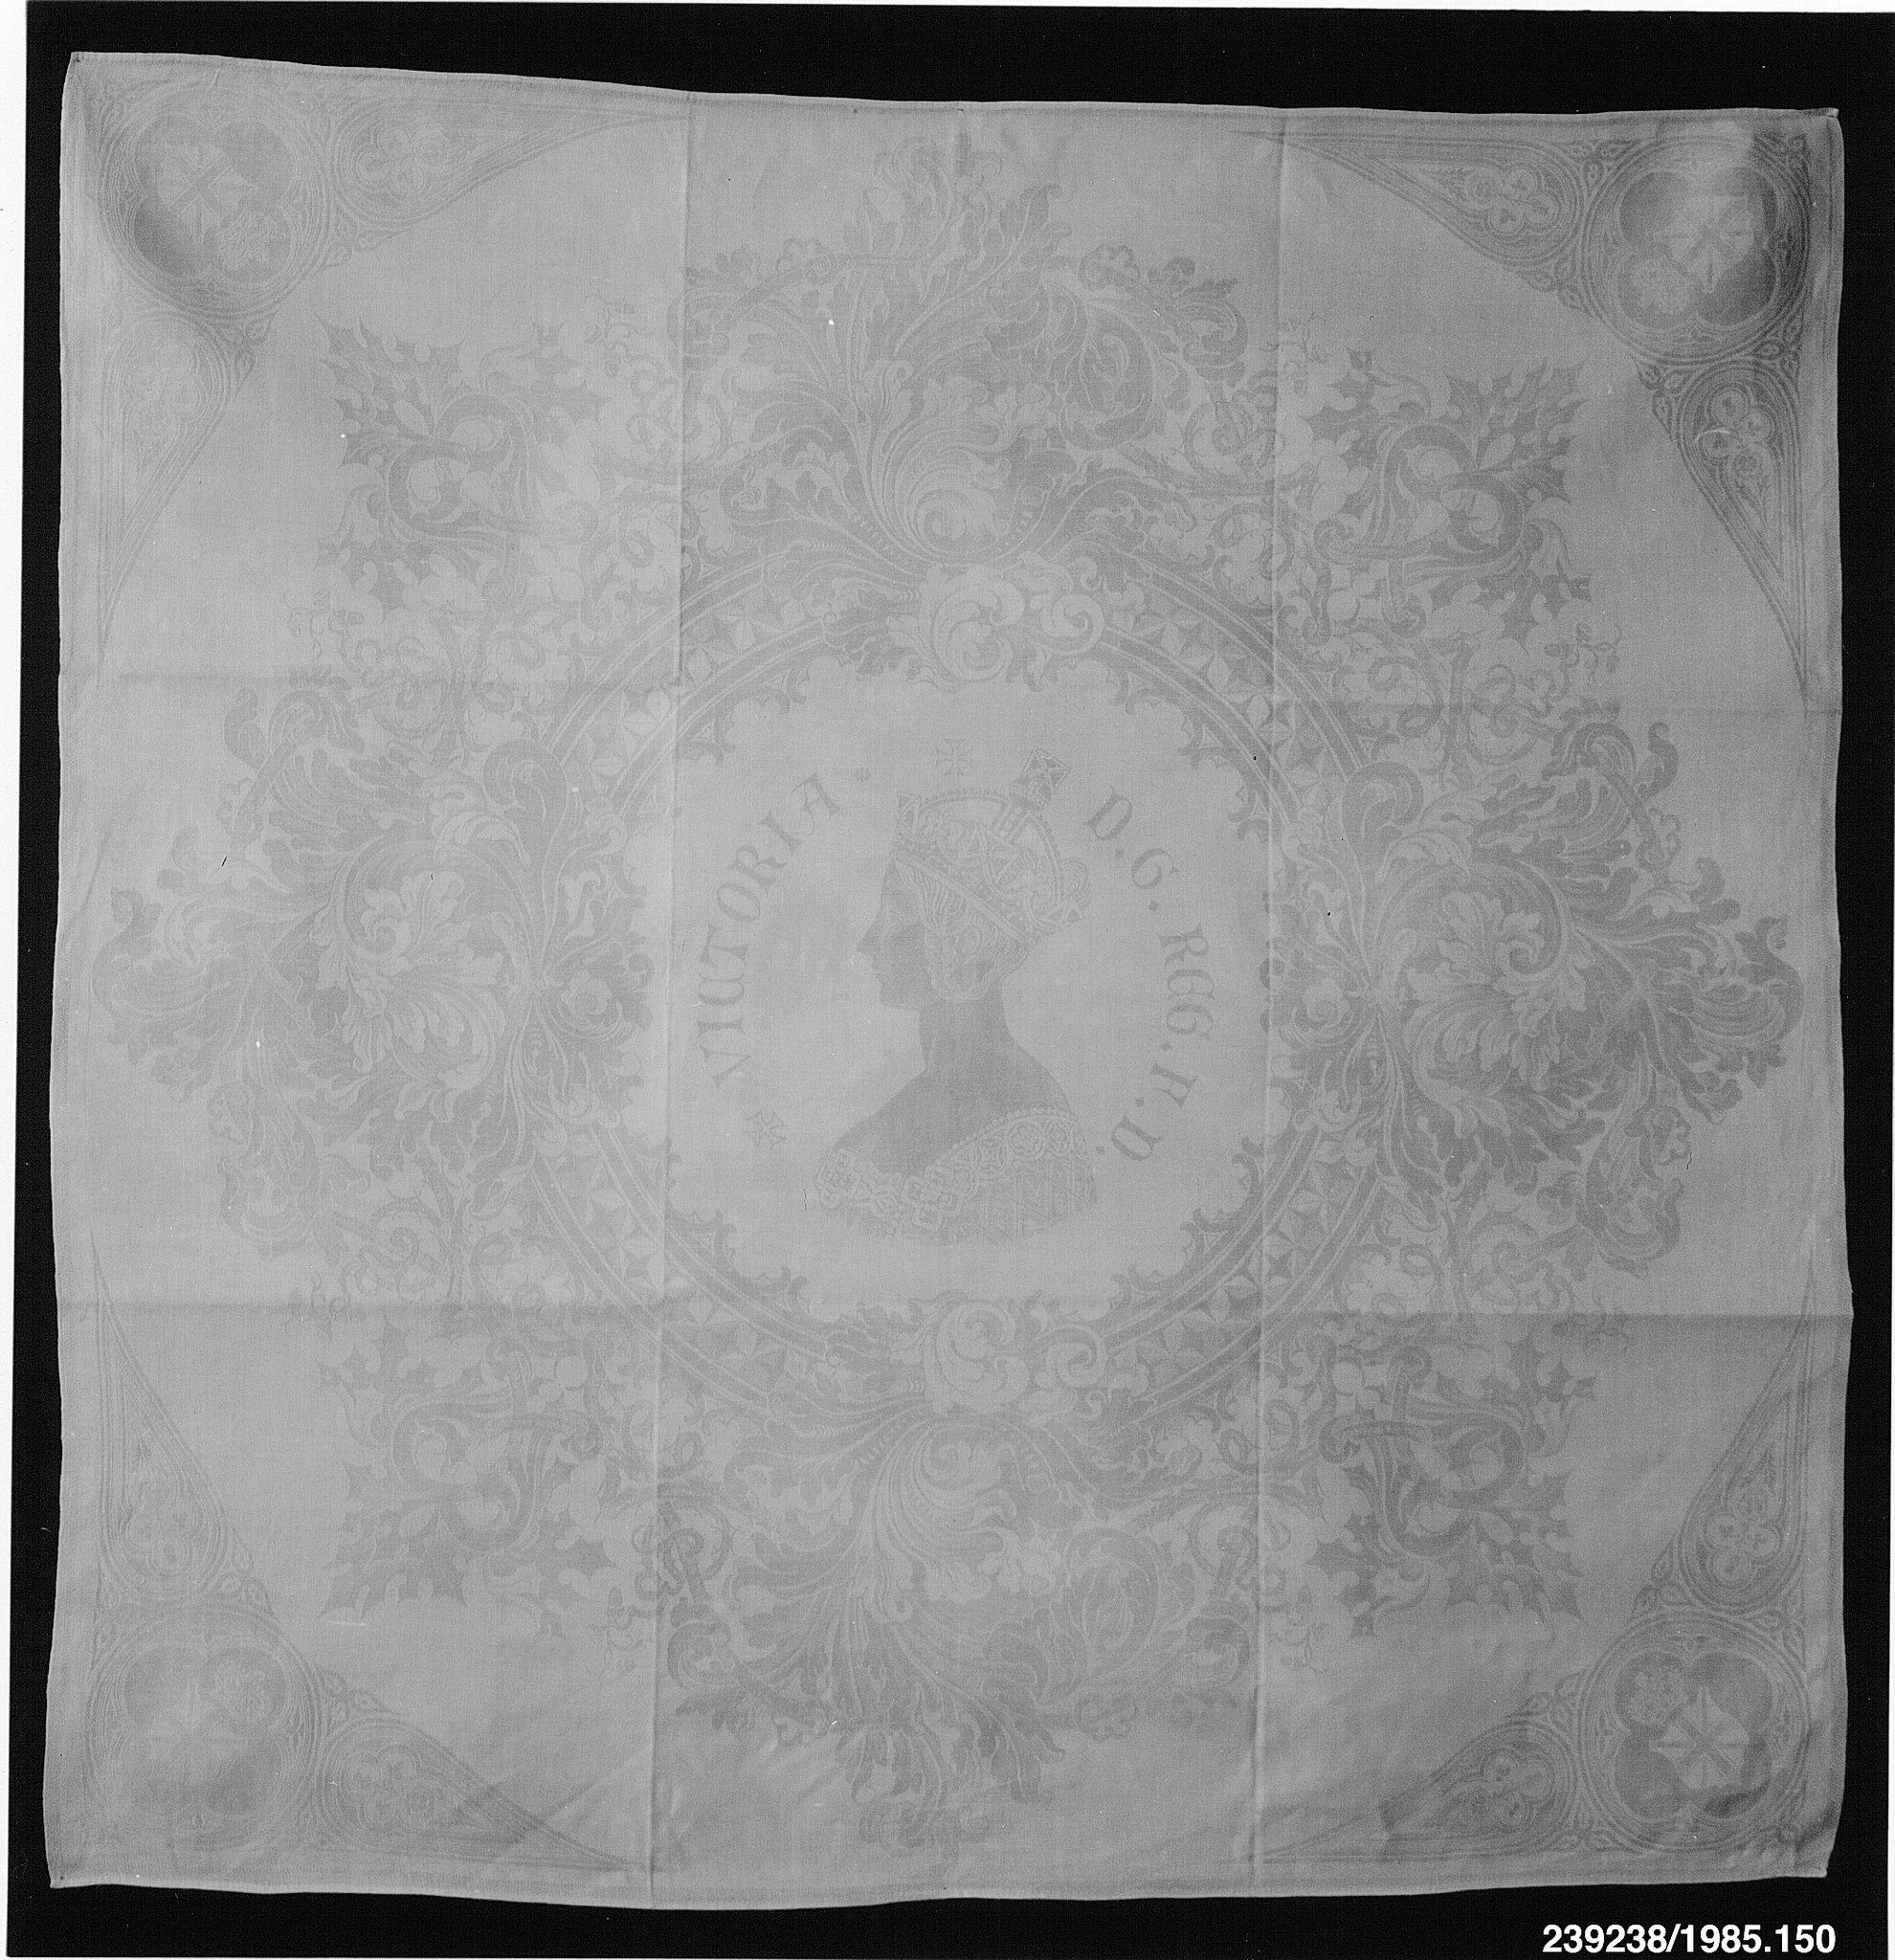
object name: napkin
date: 1834-1866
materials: linen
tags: profiles,women,queen victoria